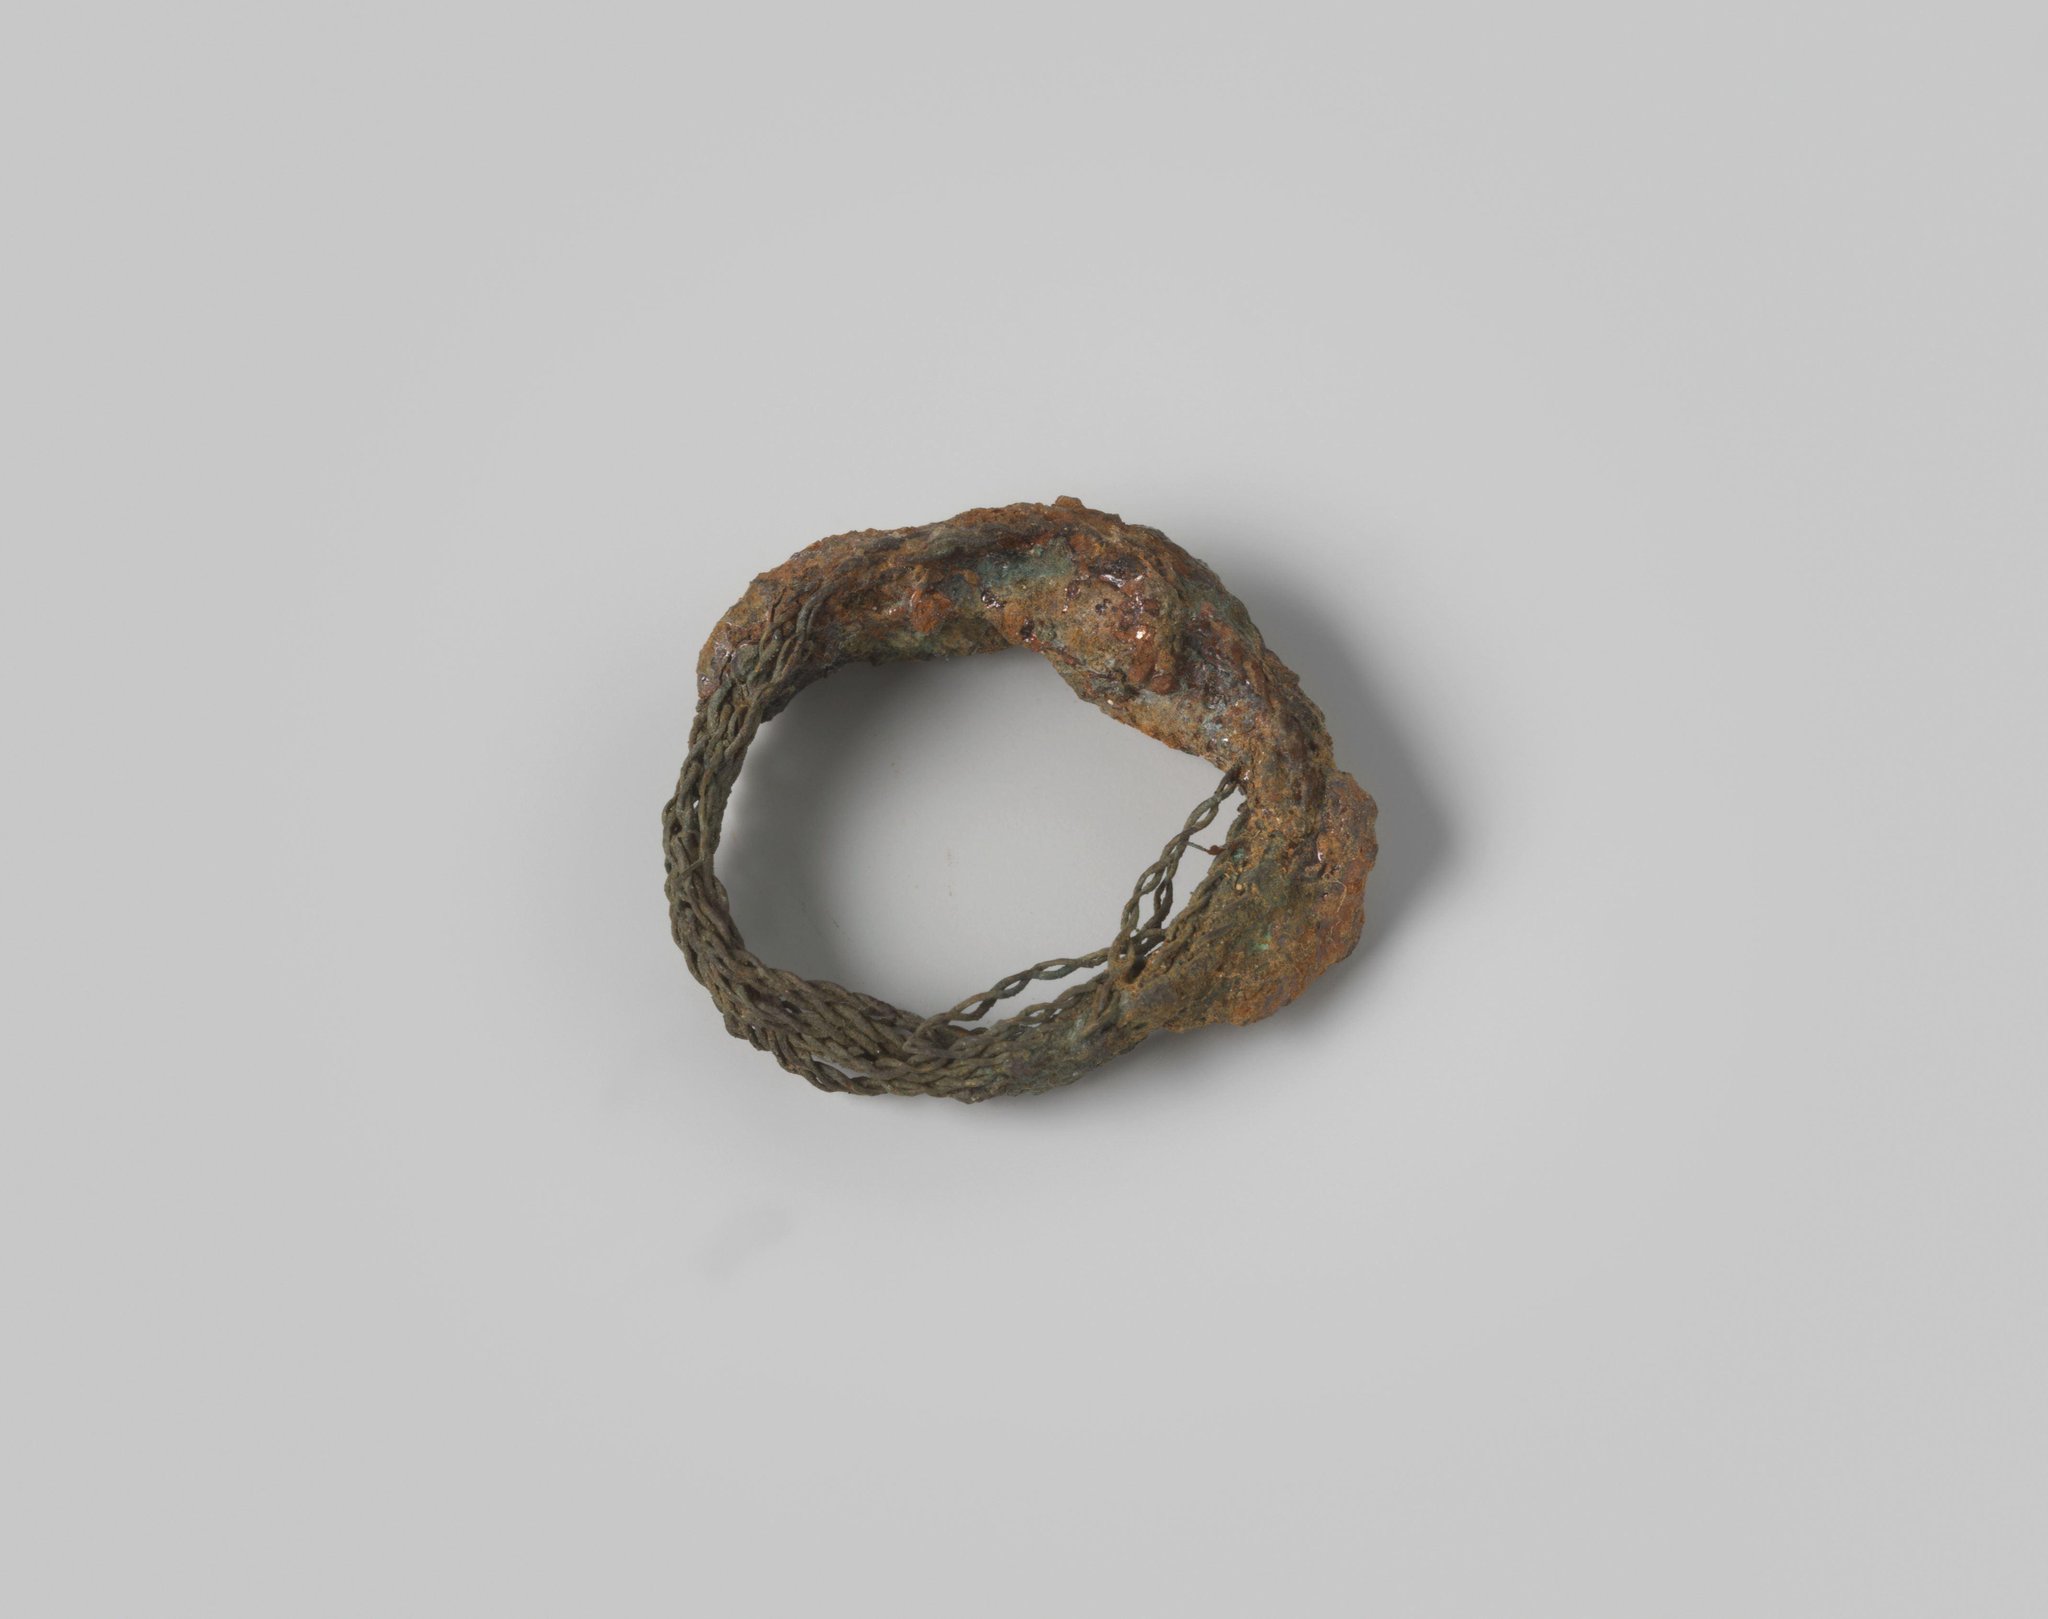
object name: ferrule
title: Beslagring van de greep van een gevest uit het wrak van de Oost-Indiëvaarder Hollandia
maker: Anonymous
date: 1700-1743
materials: copper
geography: netherlands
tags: verenigde oostindische compagnie, hollandia (schip), annet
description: Hilt, grip, ferrule; id. NG 1980-27H2582.